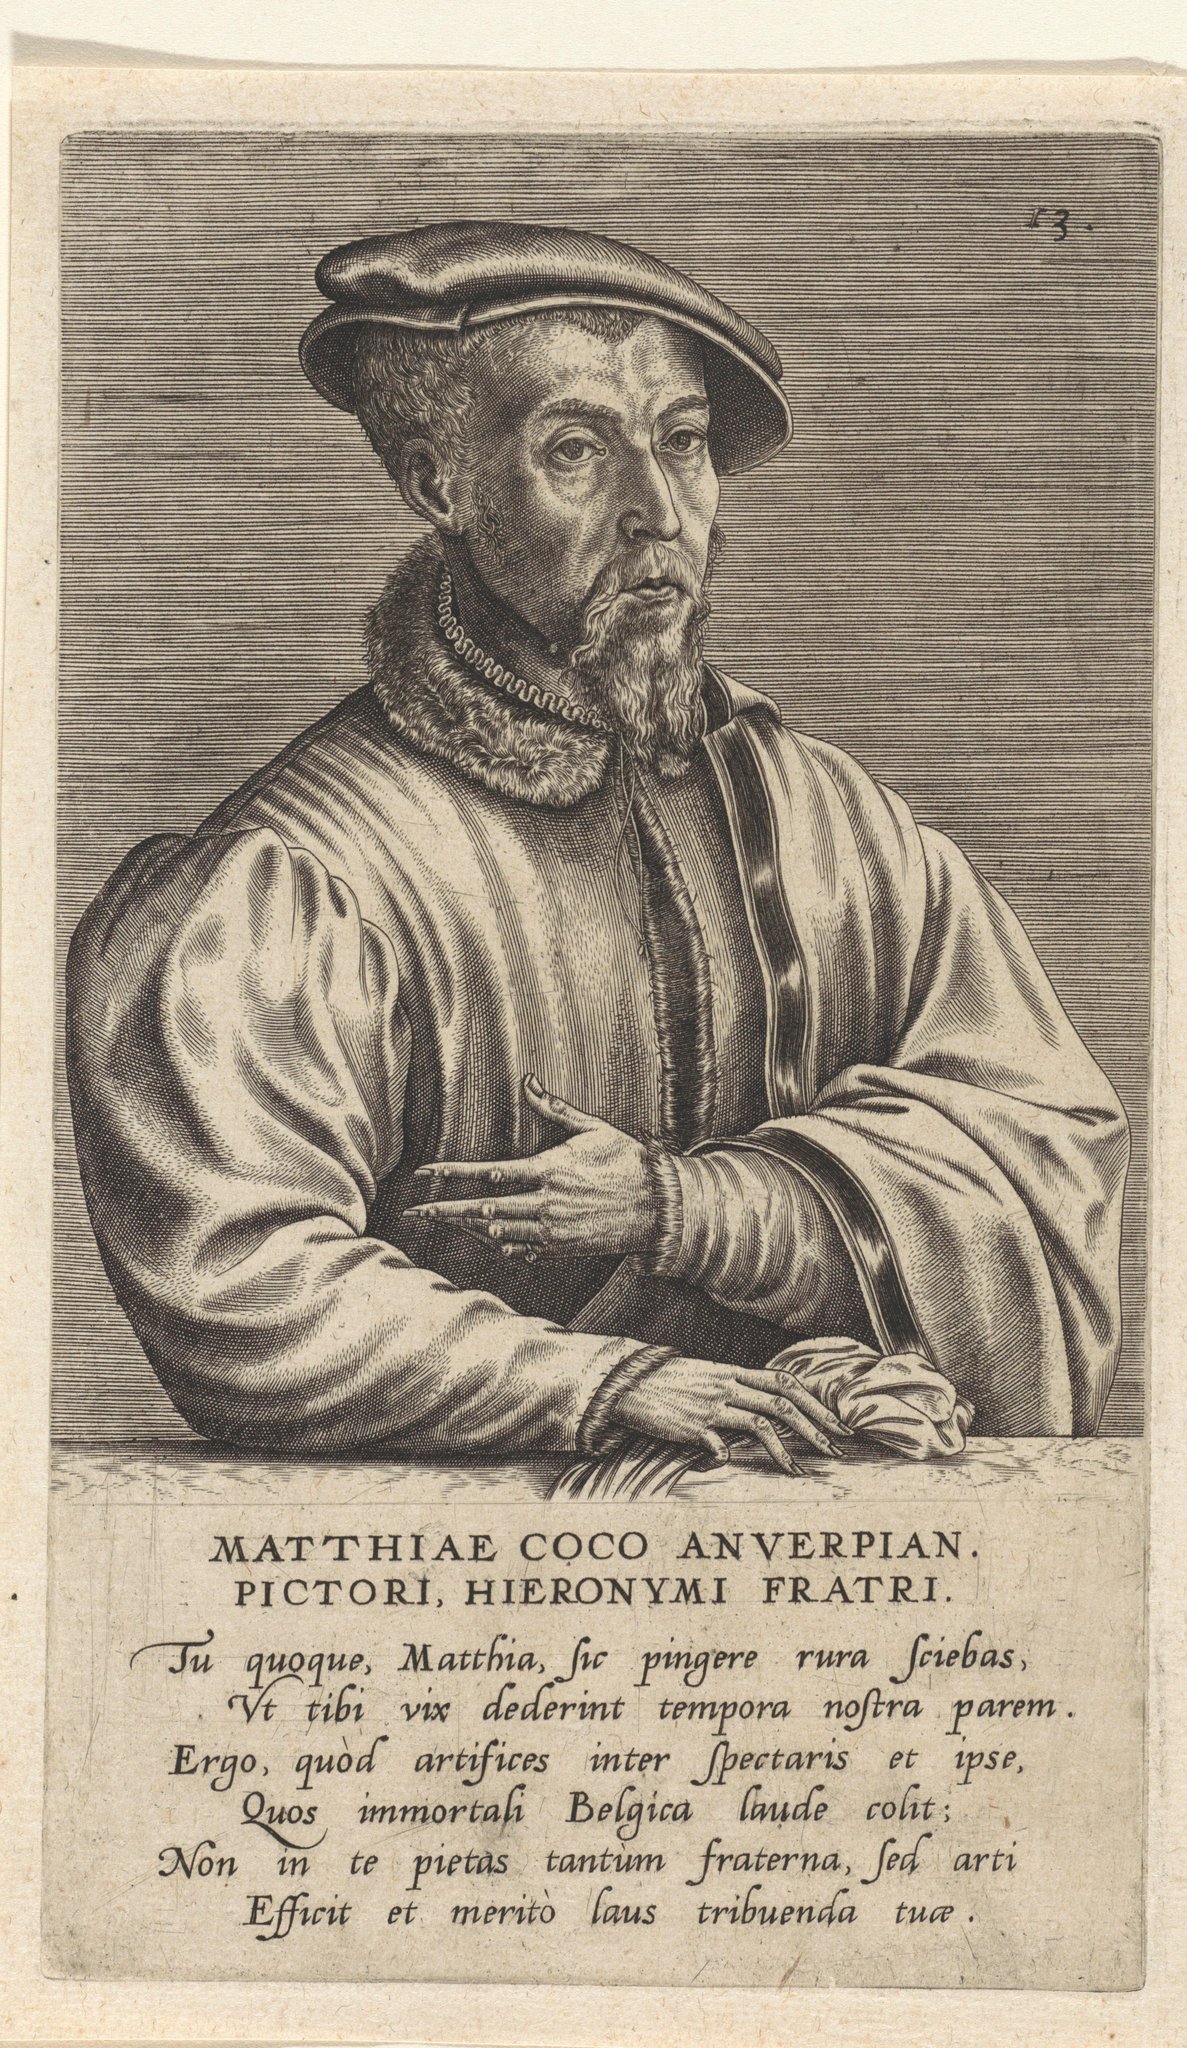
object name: print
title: Portretten van schilders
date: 1572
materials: paper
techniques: engraving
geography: antwerp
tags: antwerp, draughtsman, matthys cock, portrait, self-portrait of painter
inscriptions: collector's mark: Lugt 2228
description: In de marge een zesregelig onderschrift in het Latijn.